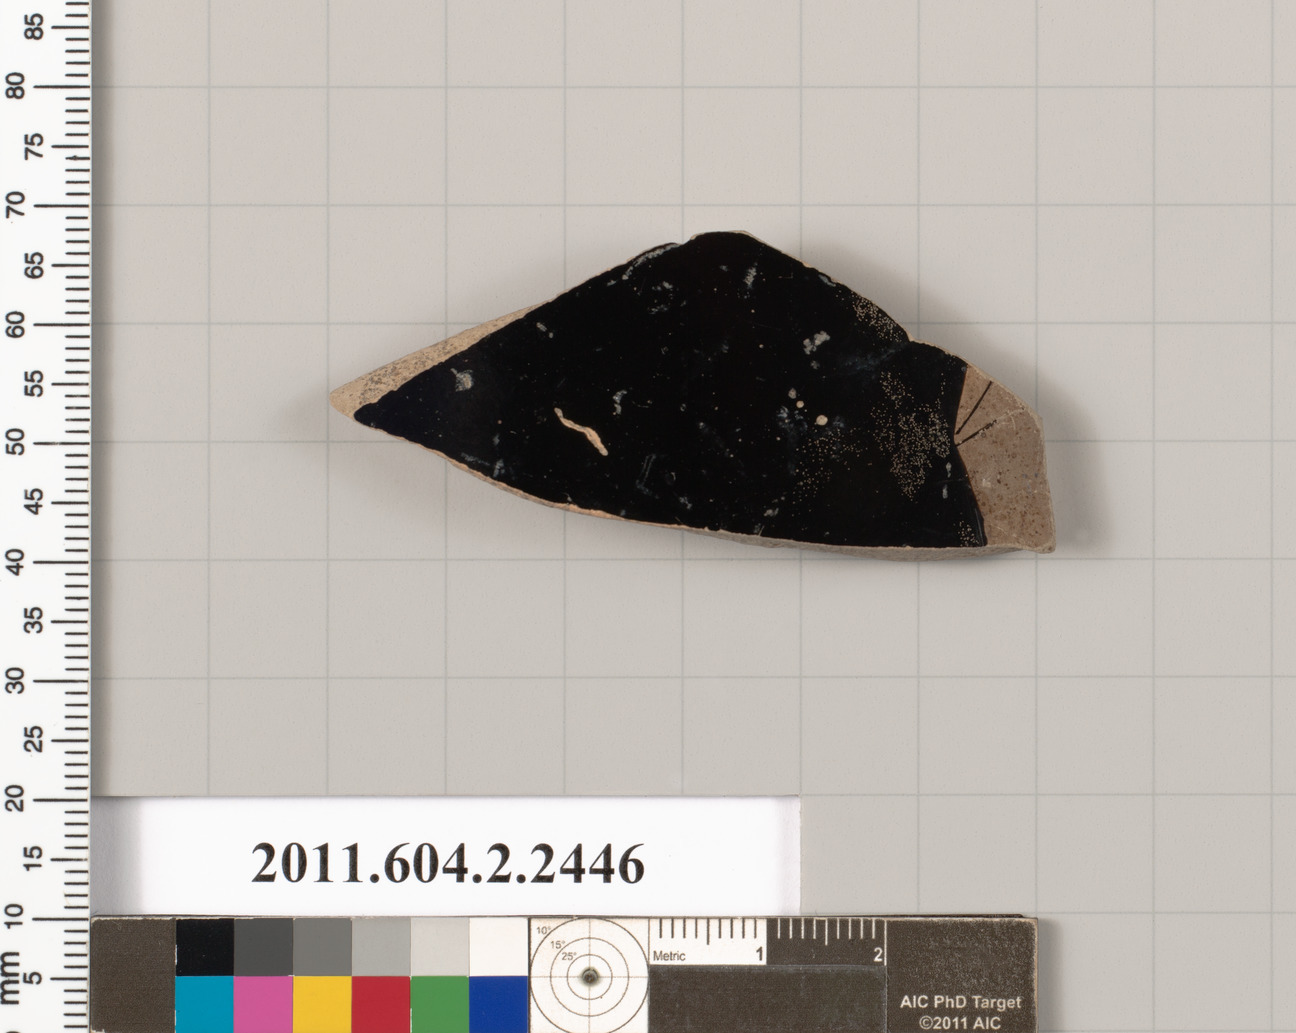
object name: krater fragment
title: Terracotta fragment of a krater (bowl for mixing wine and water)?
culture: greek, attic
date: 475-451 BCE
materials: terracotta